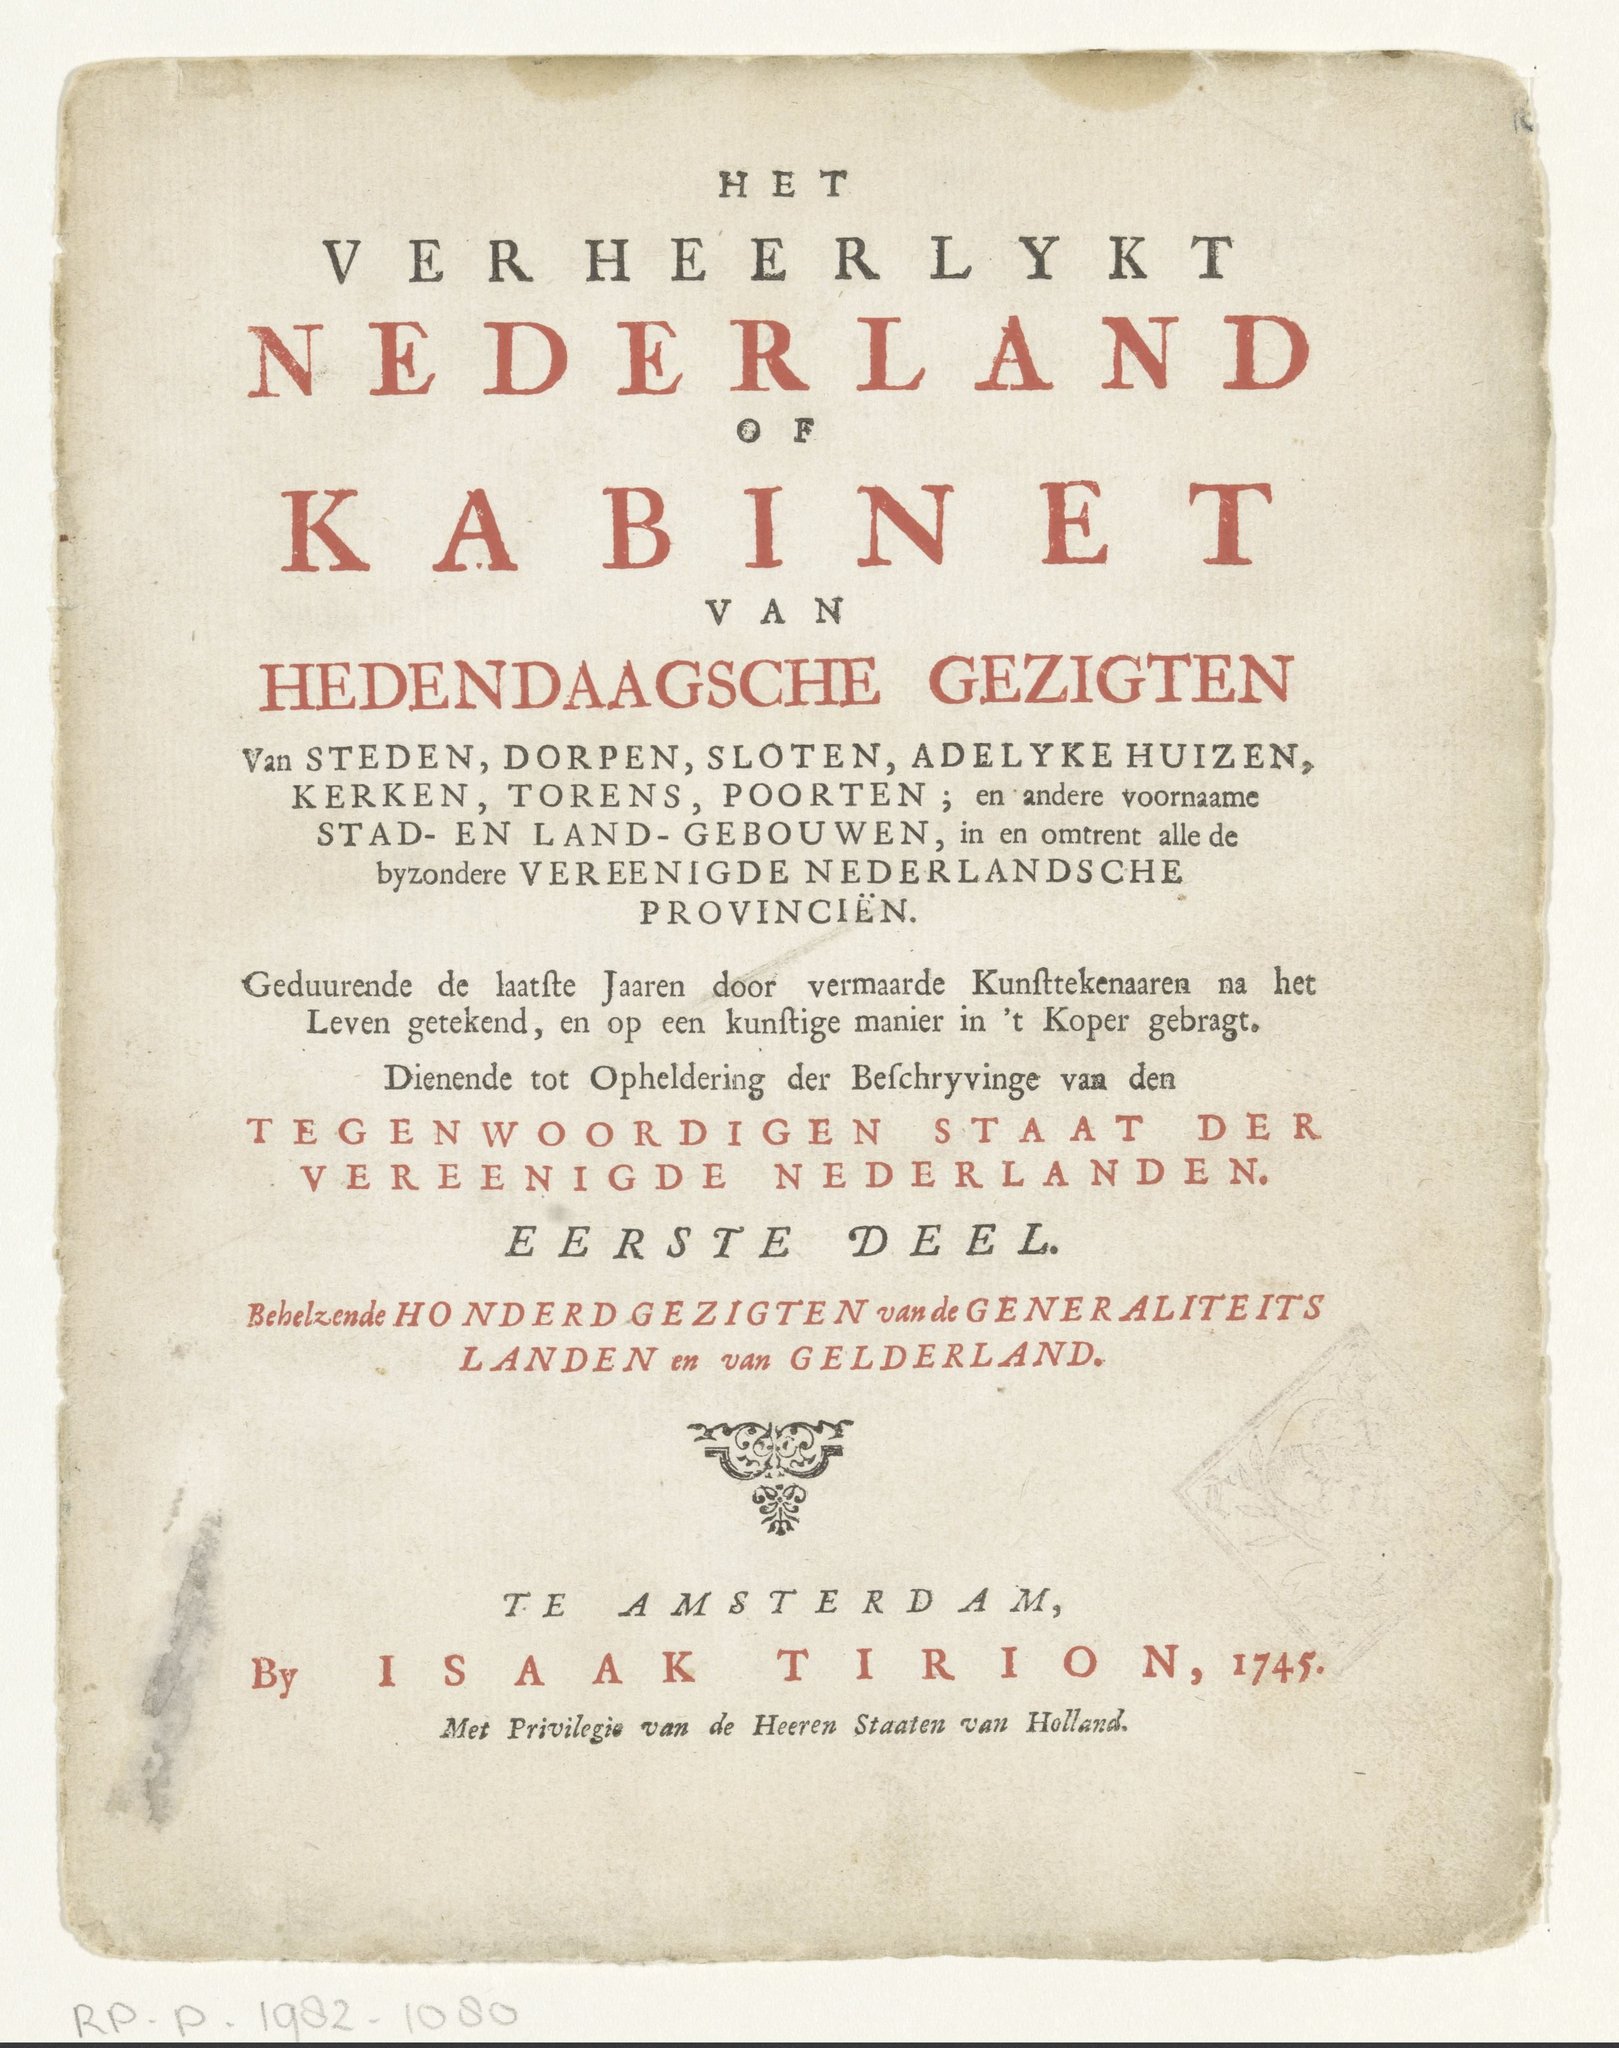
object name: print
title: Titelpagina voor: S.n., Het Verheerlijkt Nederland, eerste deel, 1745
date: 1745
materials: paper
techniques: letterpress printing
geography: amsterdam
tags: title-page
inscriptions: collector's mark: Lugt 2760, stamp, collector's mark: Lugt 2228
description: Titelpagina voor: S.n. Het Verheerlijkt Nederland, eerste deel. Amsterdam: Tirion, Isaak, 1745.